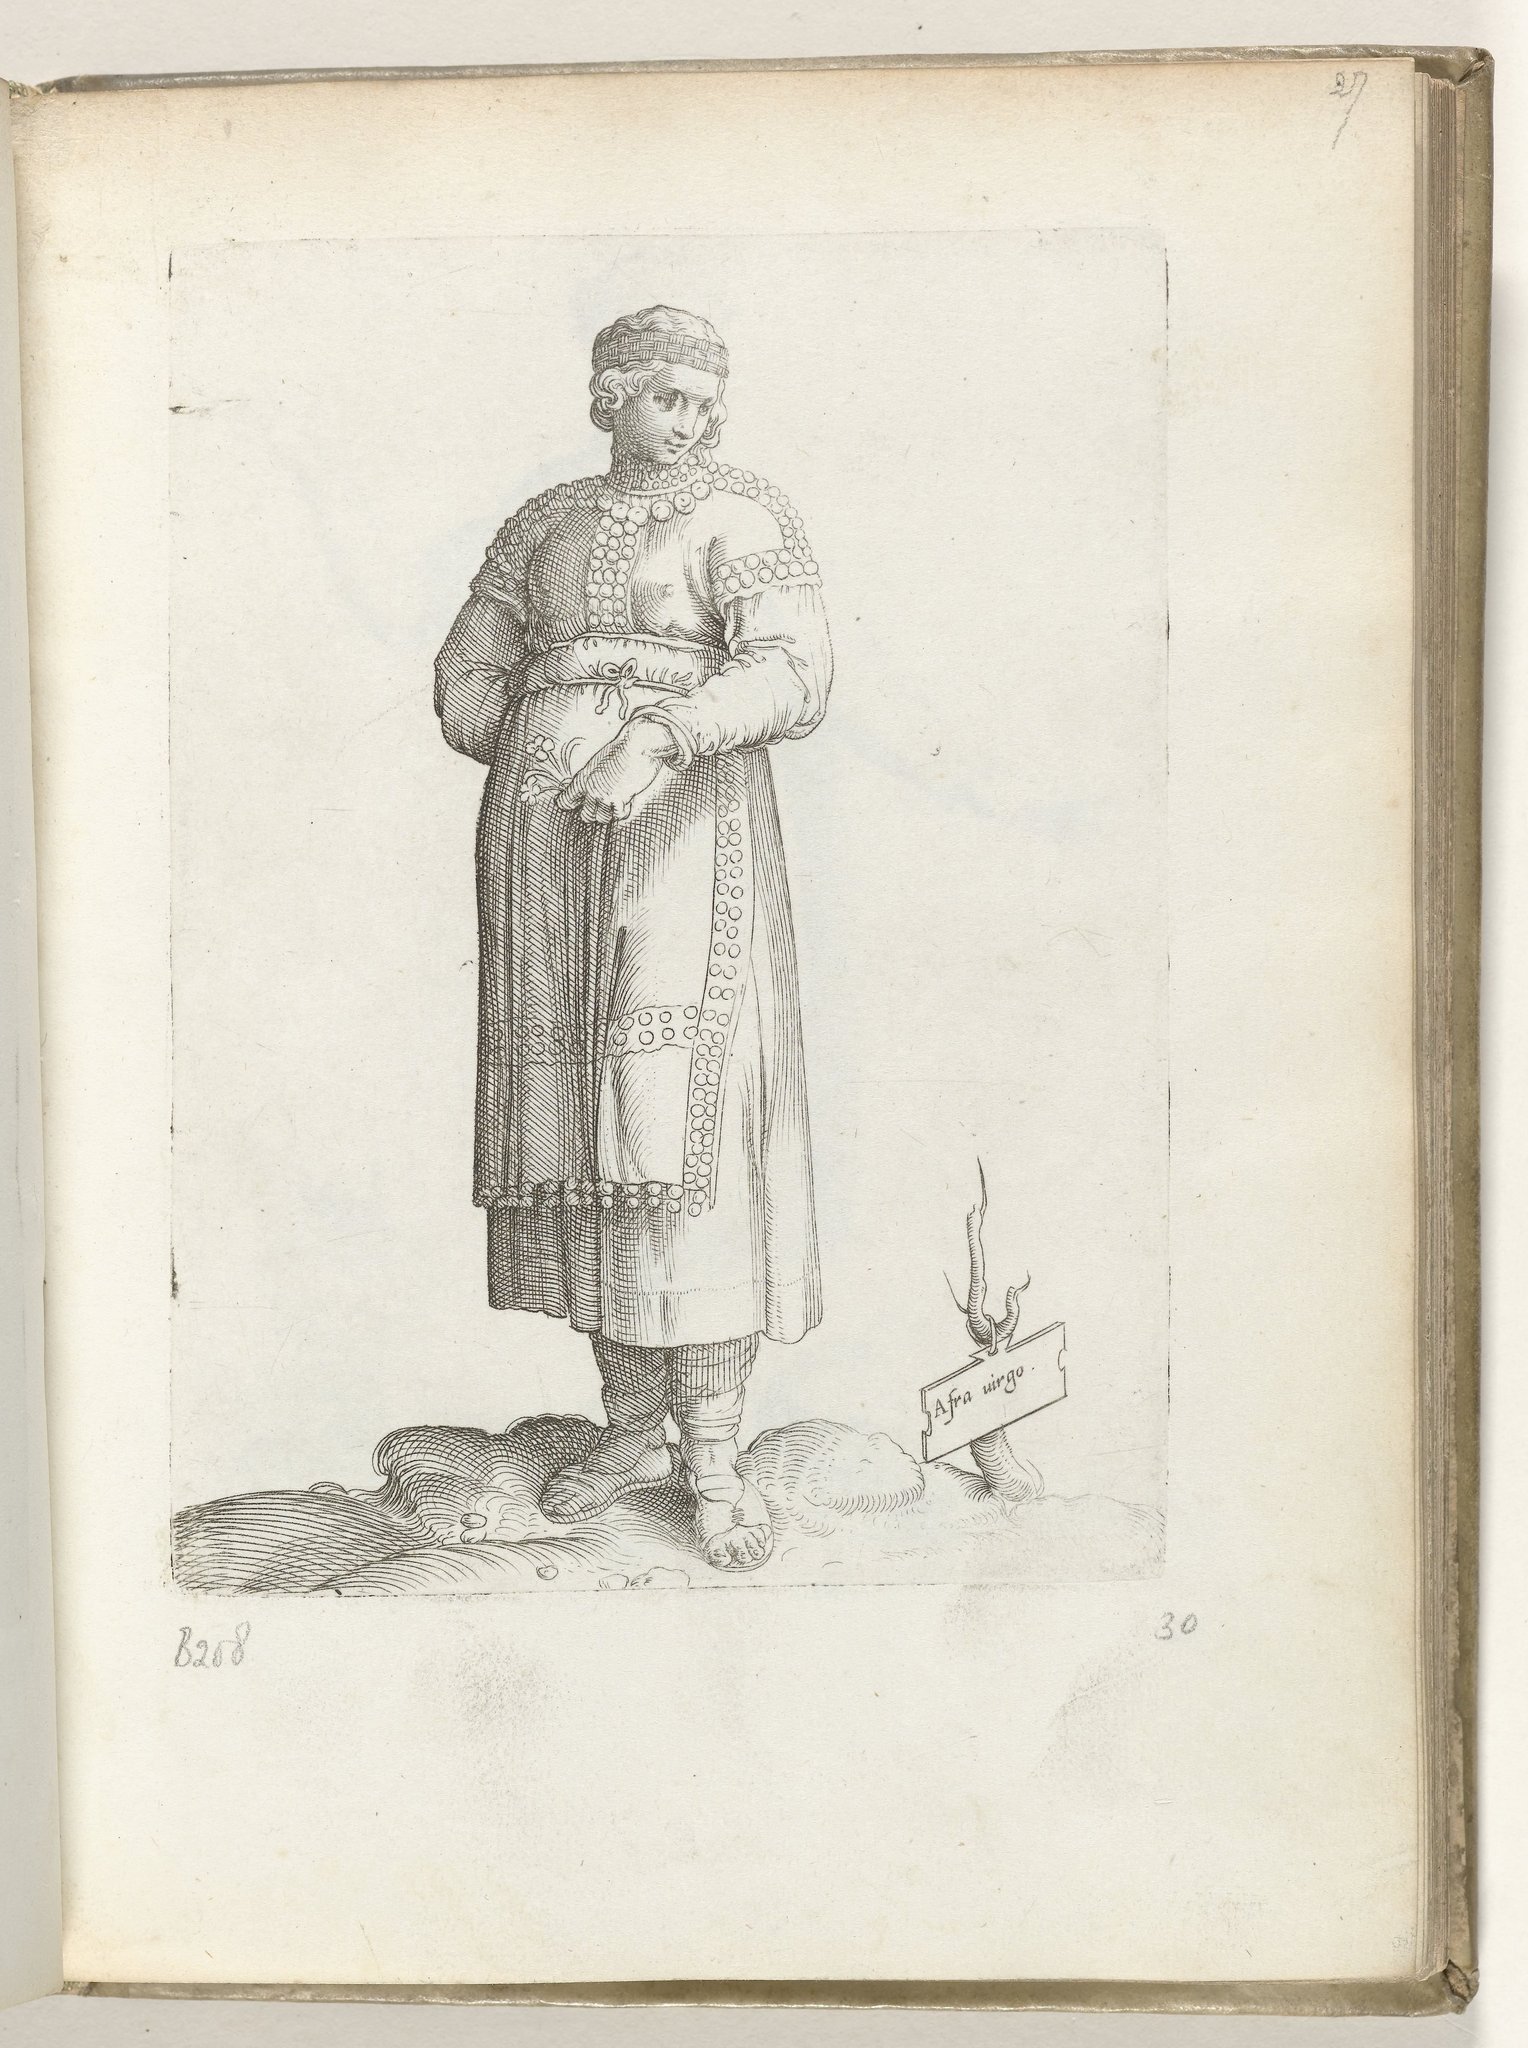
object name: costume print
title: Afra virgo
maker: enea vico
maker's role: draughtsman, print maker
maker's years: 1523-1567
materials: paper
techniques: engraving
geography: venice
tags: africans (+ costume), fashion plates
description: Prent uit album 'Diversarum gentium nostrae aetatis habitus'.